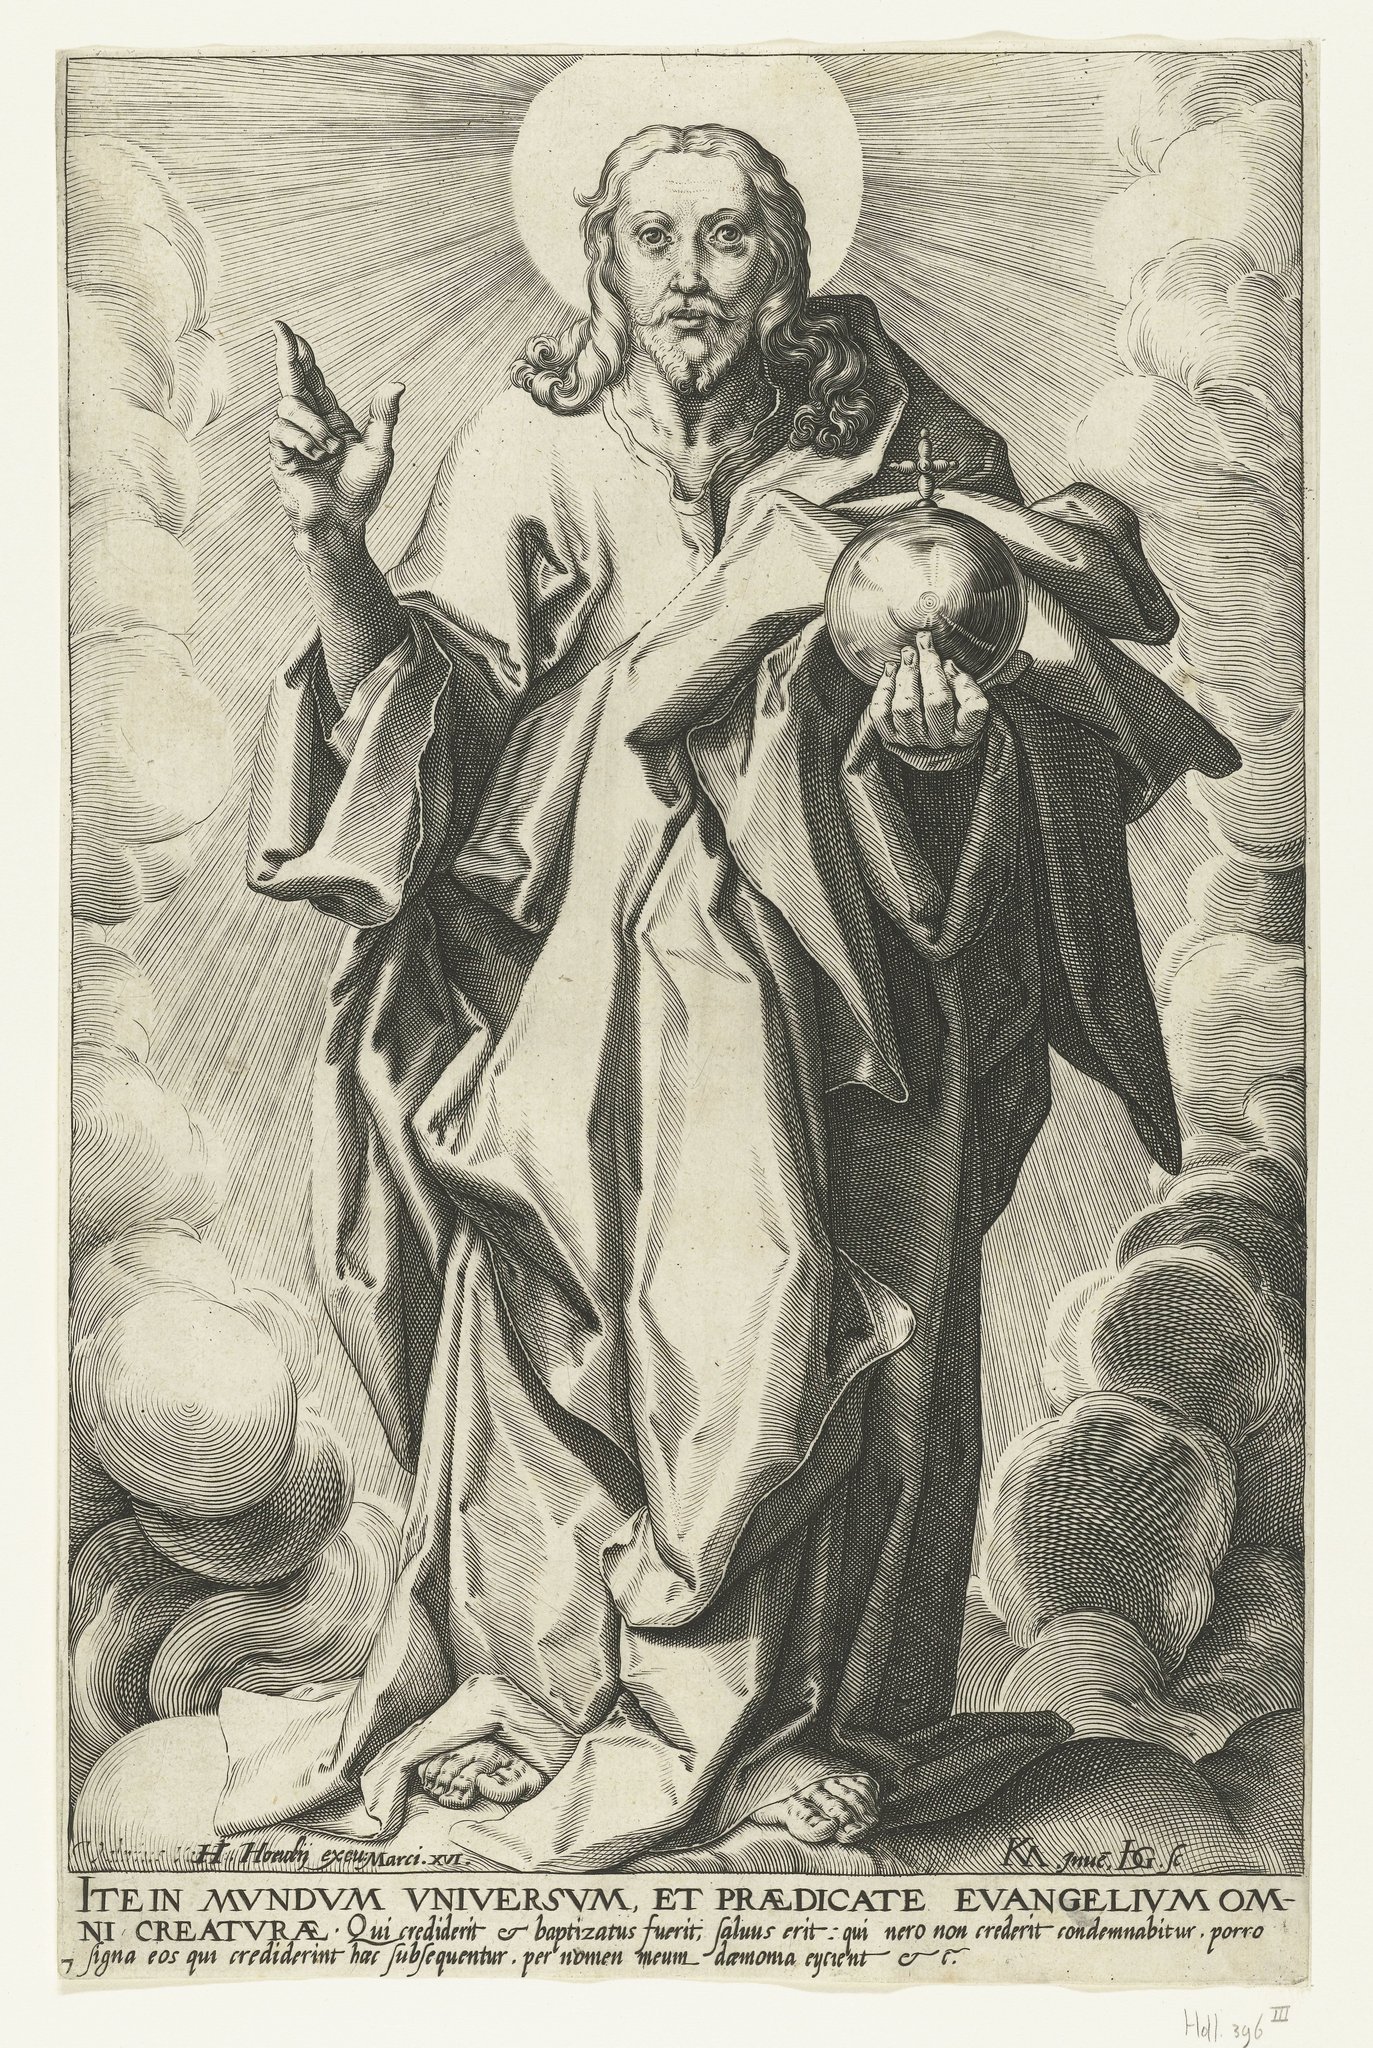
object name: print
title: Christus, de twaalf apostelen en de heilige Paulus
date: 1591-1592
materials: paper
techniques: engraving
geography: the hague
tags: 'salvator mundi', making a blessing gesture; an orb in his hand or at his feet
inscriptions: collector's mark: Lugt 2228a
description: Christus, staand temidden van wolken, de rechterhand in een zegenend gebaar, in de linkerhand een rijksappel. Onder de voorstelling drie regels Latijnse tekst. Deze prent is onderdeel van een serie van 14 prenten, elk bestaand uit een beeltenis ten voeten uit van een apostel, Christus of Paulus met typerende attributen en een onderschrift in Latijn.